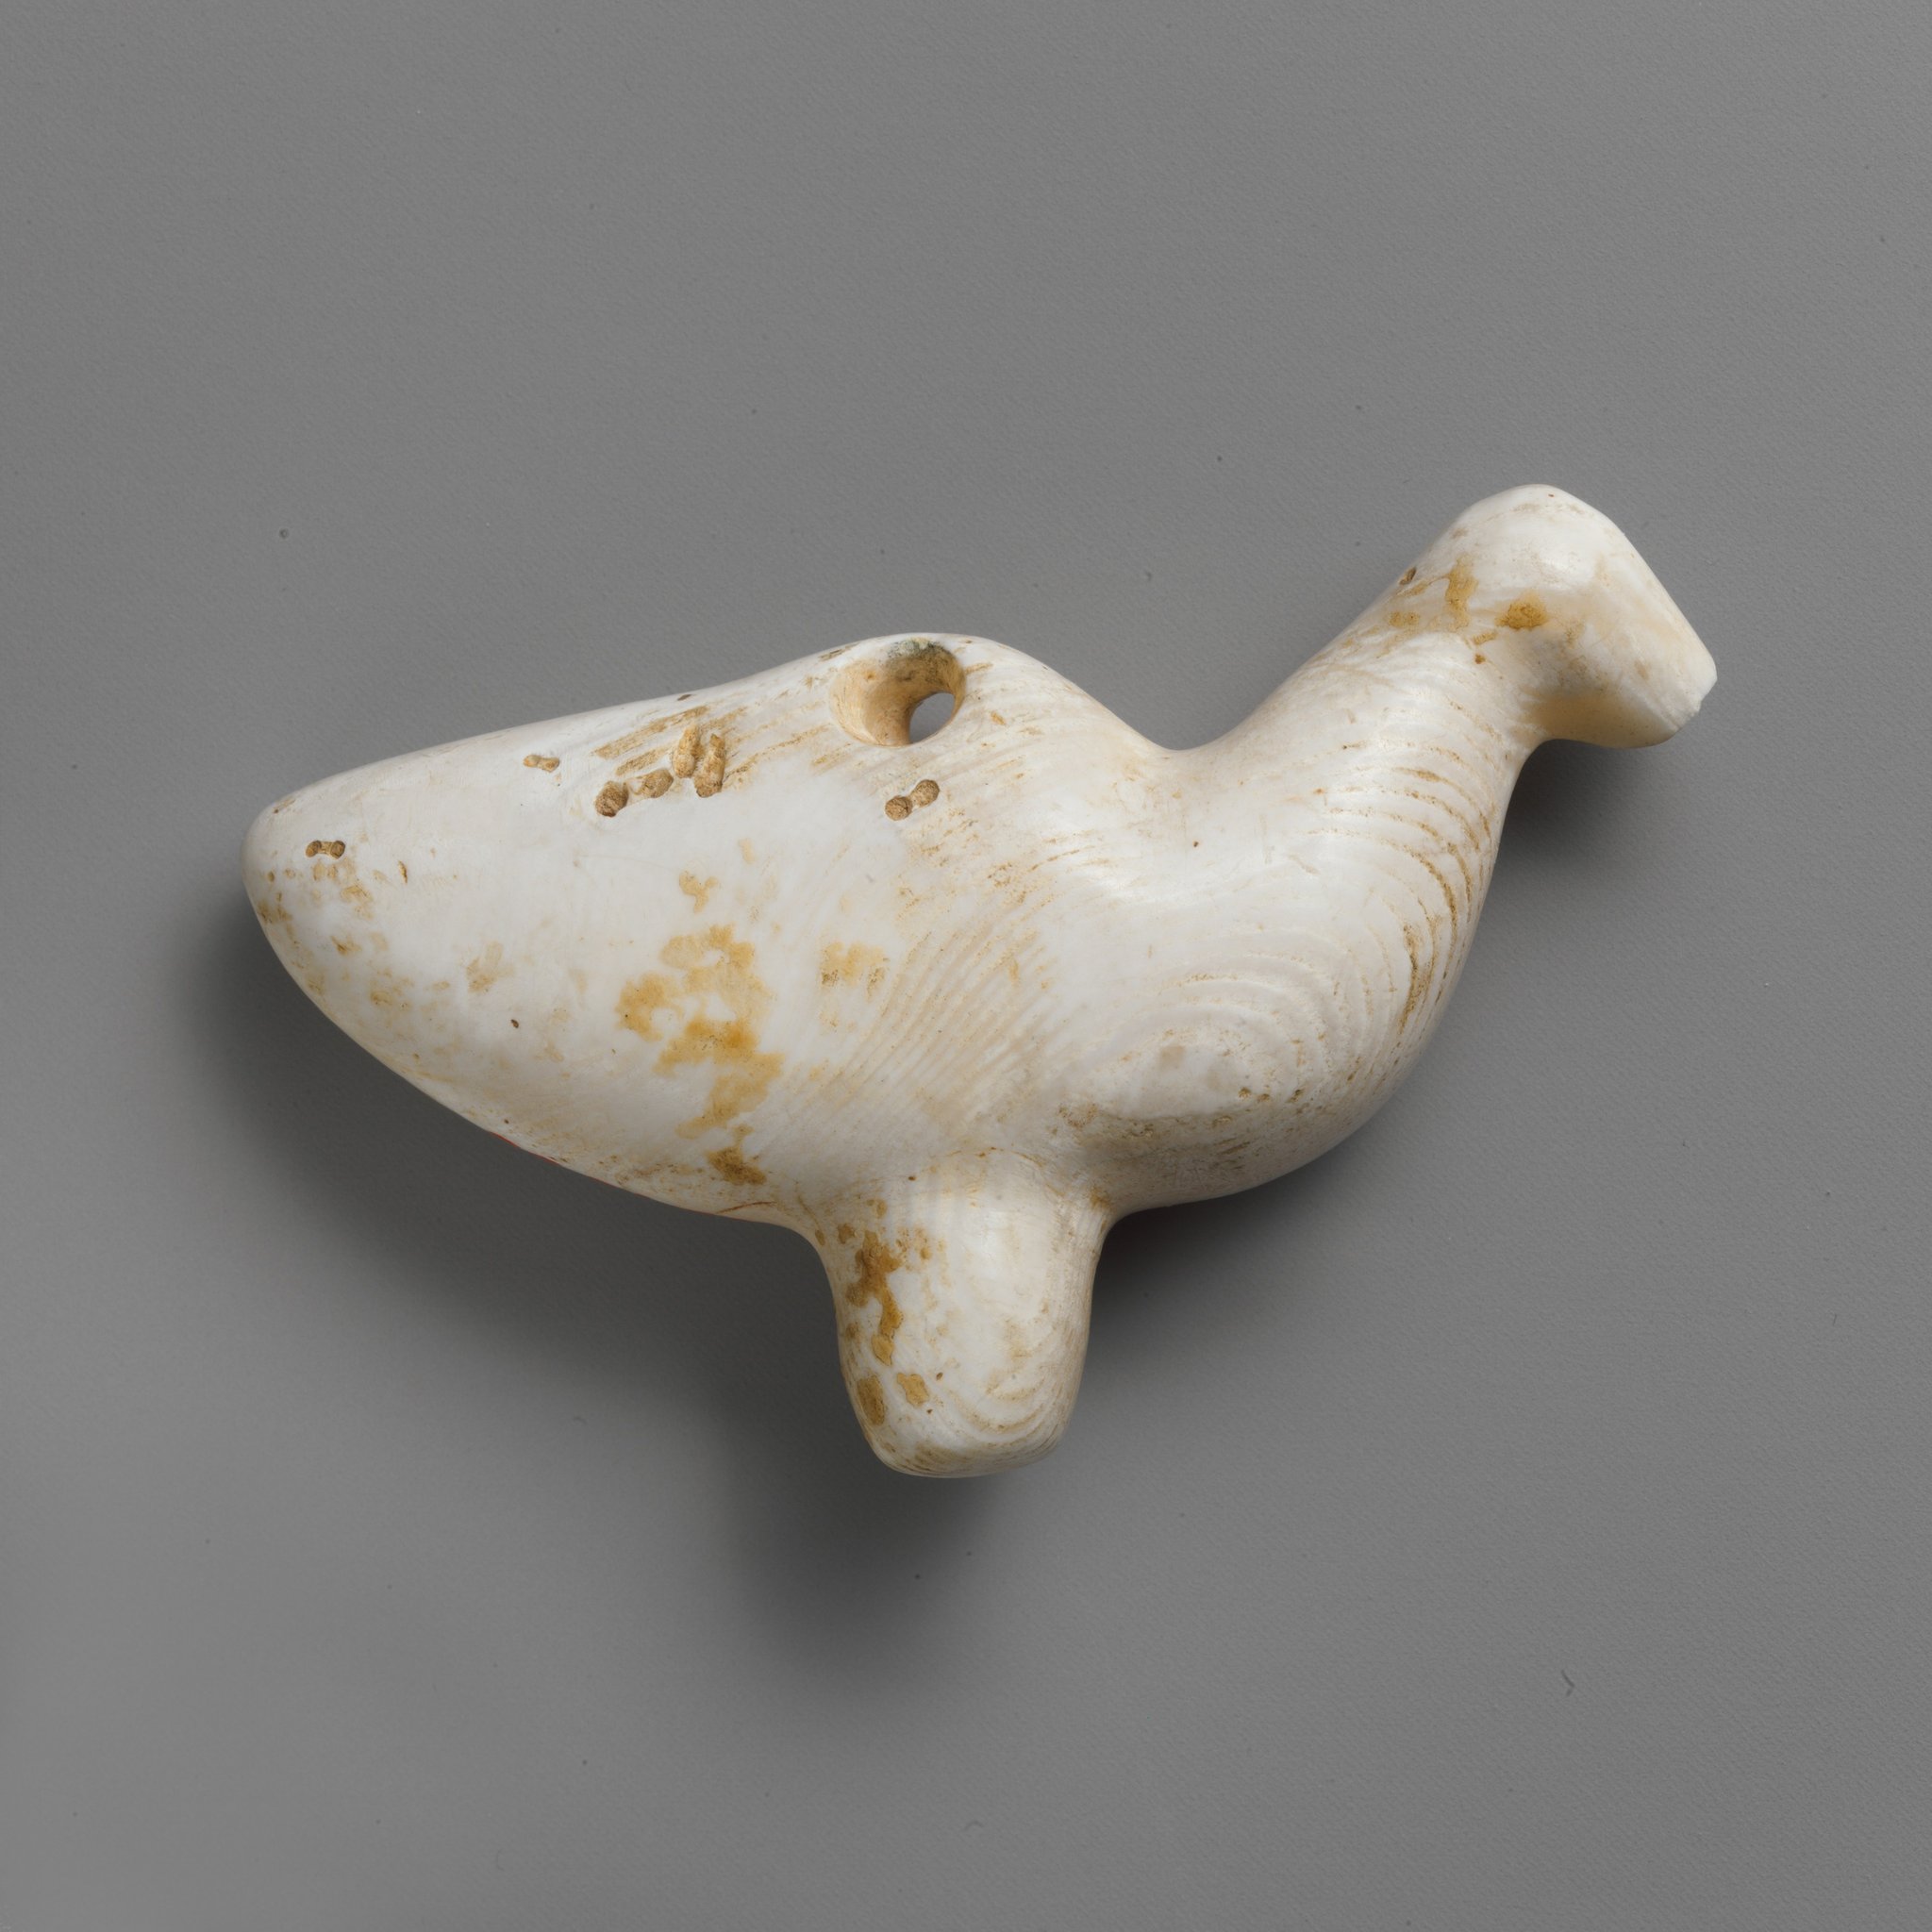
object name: pendant in the form of a duck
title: Alabaster pendant in the form of a bird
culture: minoan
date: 2900-2200 BCE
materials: alabaster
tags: birds